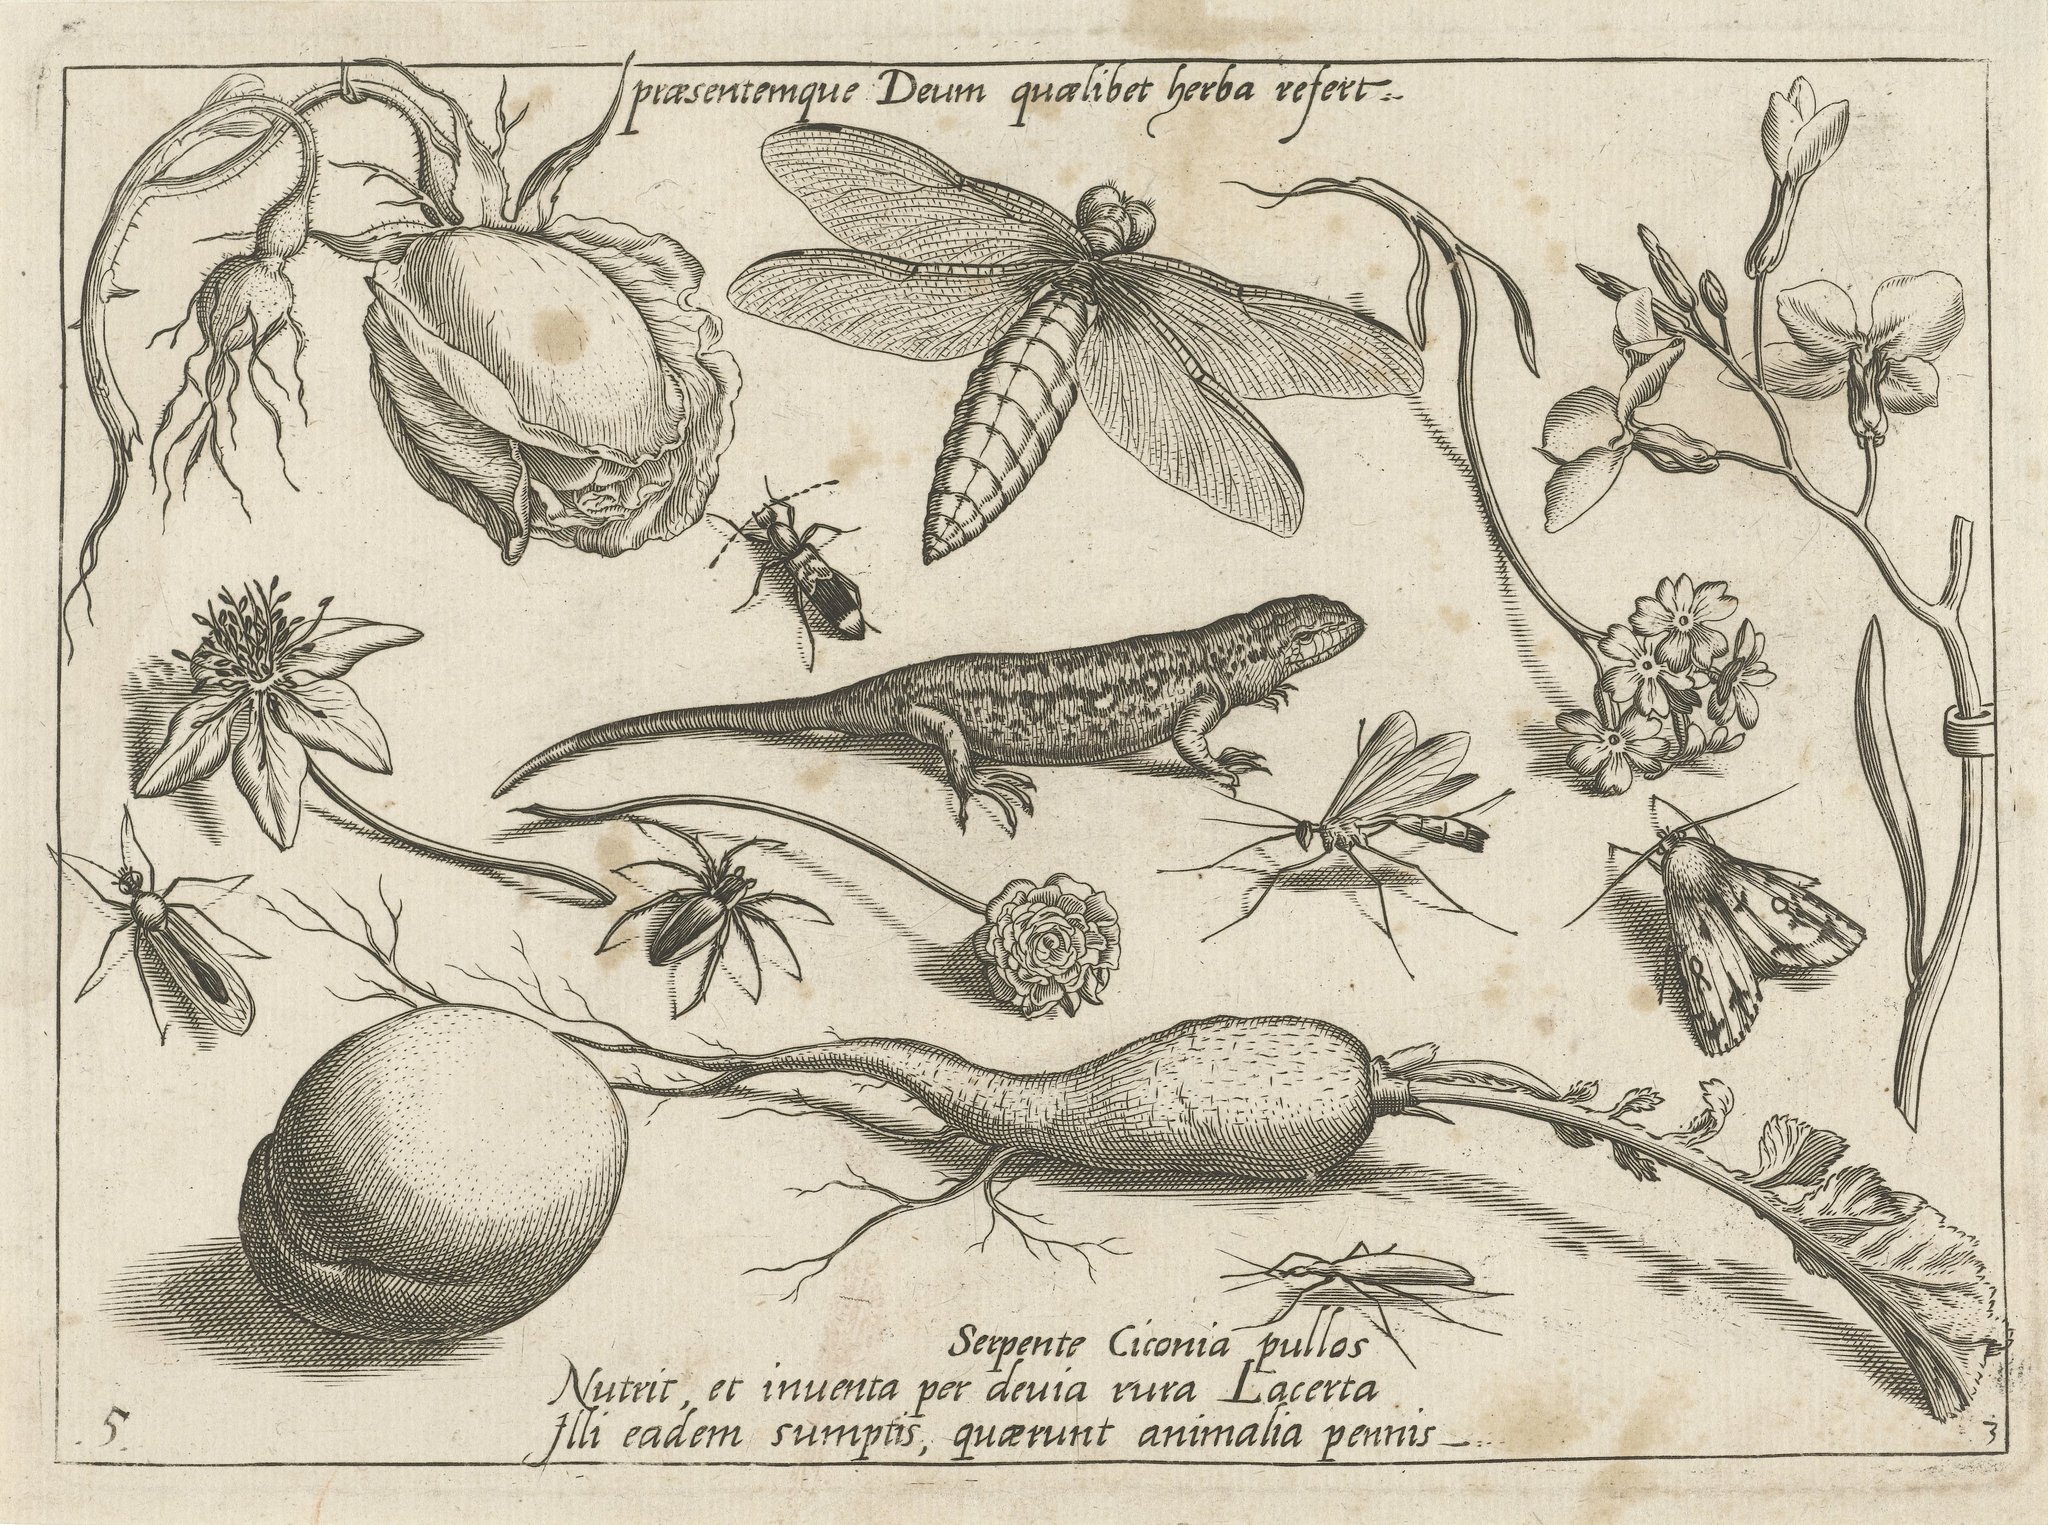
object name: print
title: Insecten, bloemen en vruchten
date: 1592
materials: paper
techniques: engraving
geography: frankfurt am main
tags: flowers, lizards: lizard, fruits: peach, flowers: rose, insects, (non-fruit) products of plants or trees: radish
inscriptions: collector's mark: Lugt 2228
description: Prent uit een serie van 48 prenten, opgedeeld in vier afzonderlijke delen van elk twaalf prenten. Rechtsonder vermeld: [deel] 3. Boven- en onderaan een tekst in het Latijn.